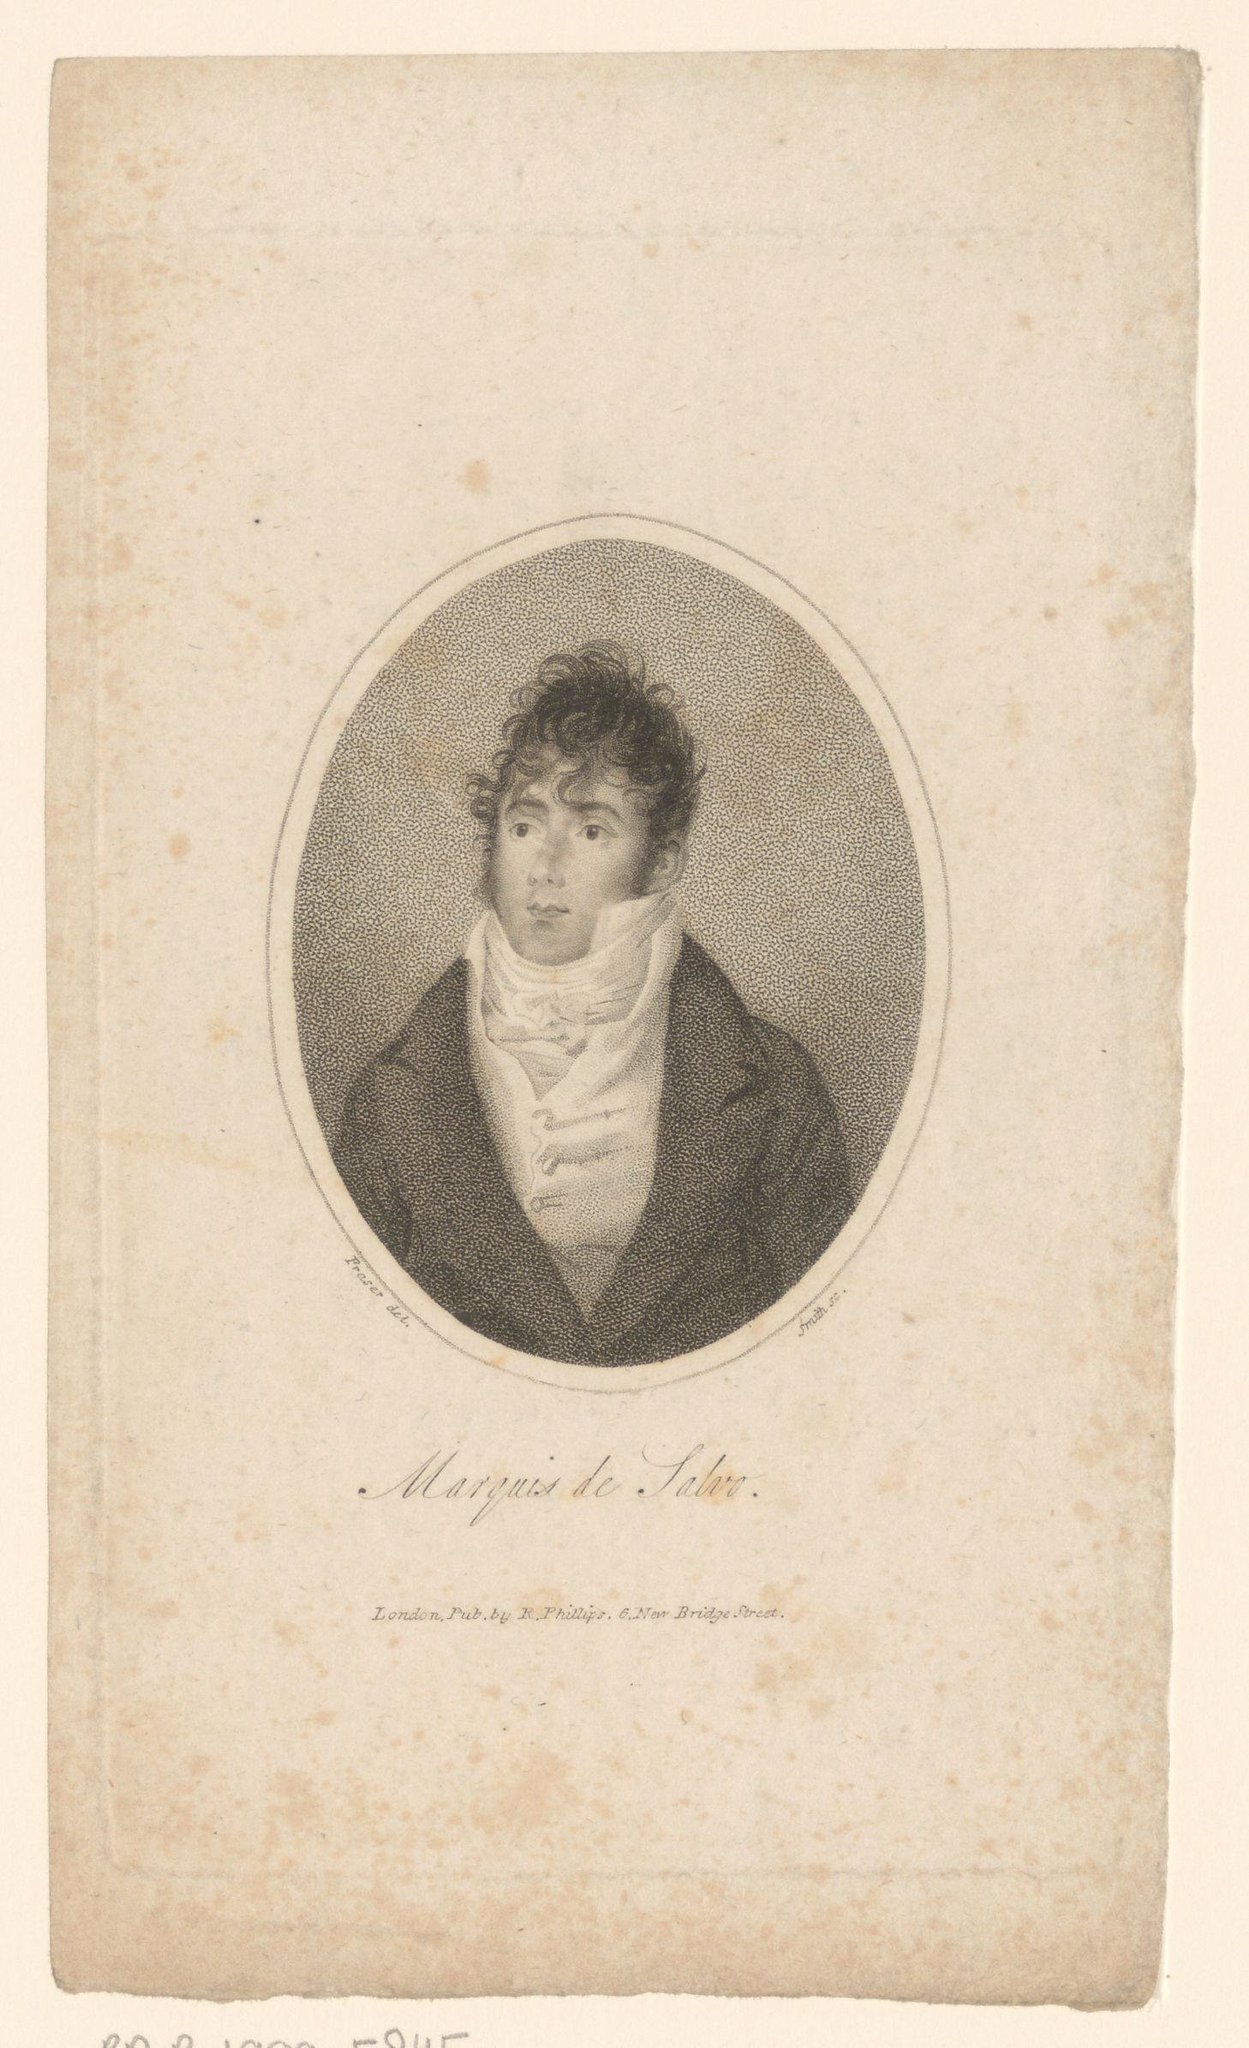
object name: print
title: Marquis de Salvo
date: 1800-1819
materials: paper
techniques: engraving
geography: london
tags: historical persons, diplomacy, diplomat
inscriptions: collector's mark: Lugt 2228